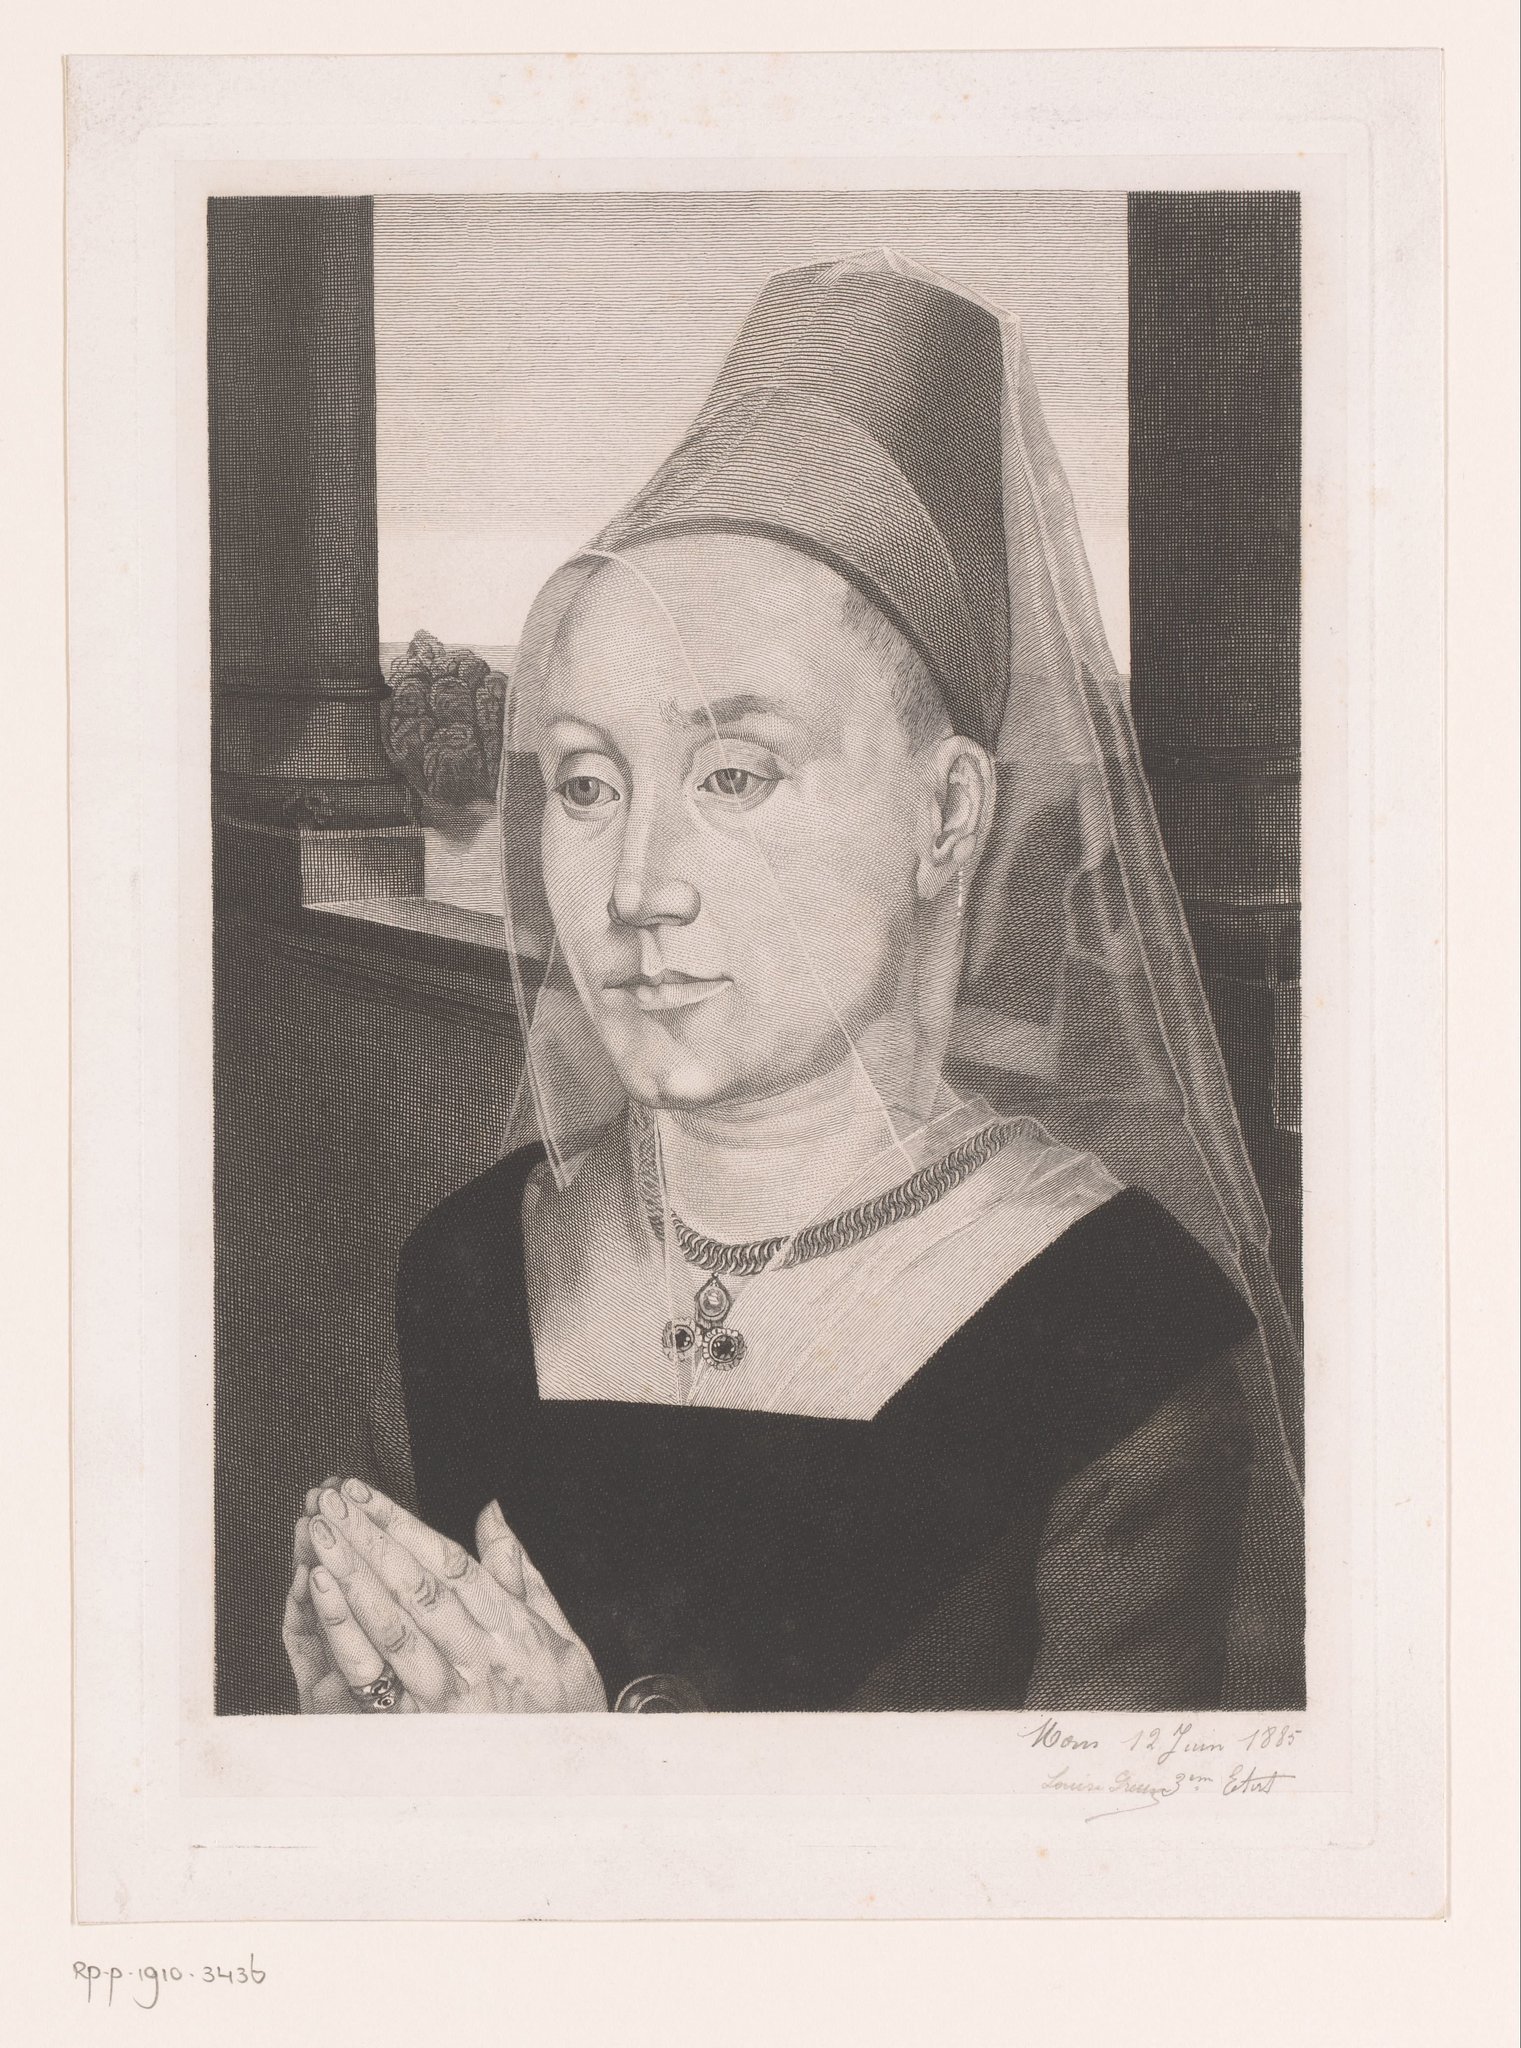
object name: print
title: Portret van Barbara van Vlaendenbergh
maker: louis joseph greuse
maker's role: print maker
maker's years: 1863-1950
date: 1885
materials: paper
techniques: engraving, etching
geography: bergen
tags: historical persons - bb - woman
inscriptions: annotation: ‘3em Etat’, annotation: ‘La femme du Bourgemestre de Bruges d'apres Memling par L. Greuze’, collector's mark: Lugt 2228